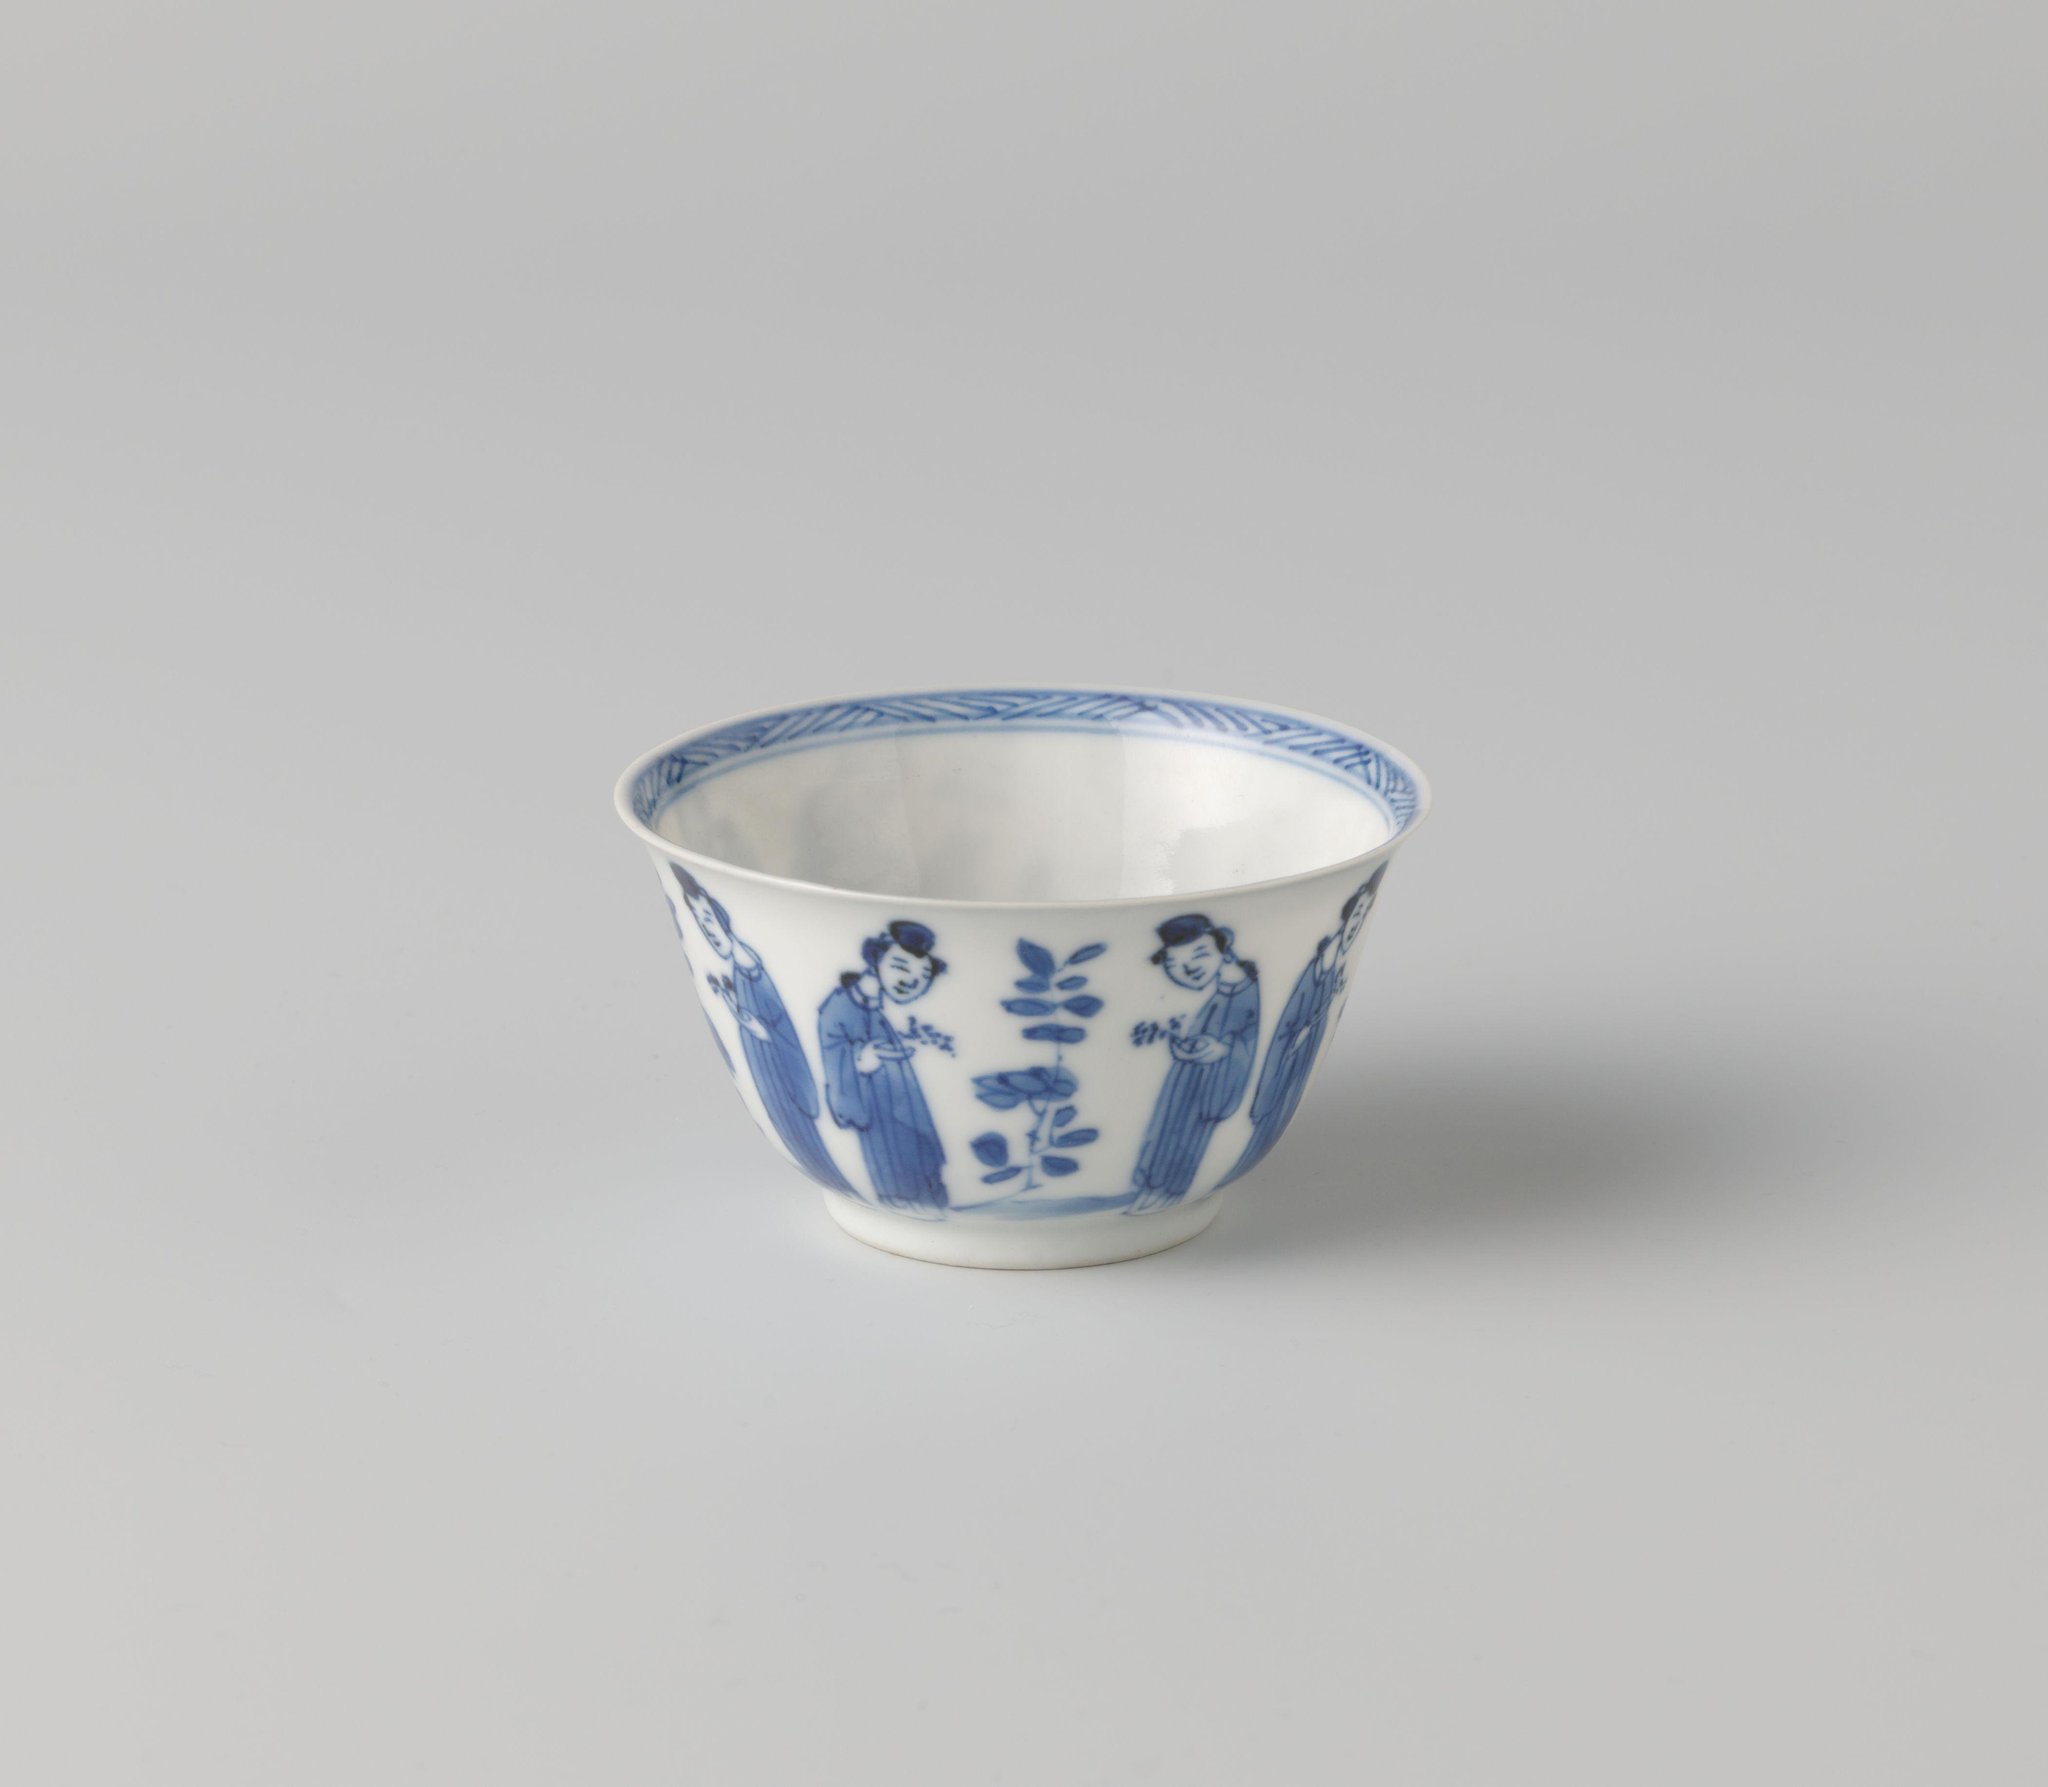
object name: cup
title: Cup with women and flower sprays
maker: Anonymous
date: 1875-1899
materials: cobalt, glaze, paint, porcelain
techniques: firing, turning, vitrification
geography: china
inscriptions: mark, mark